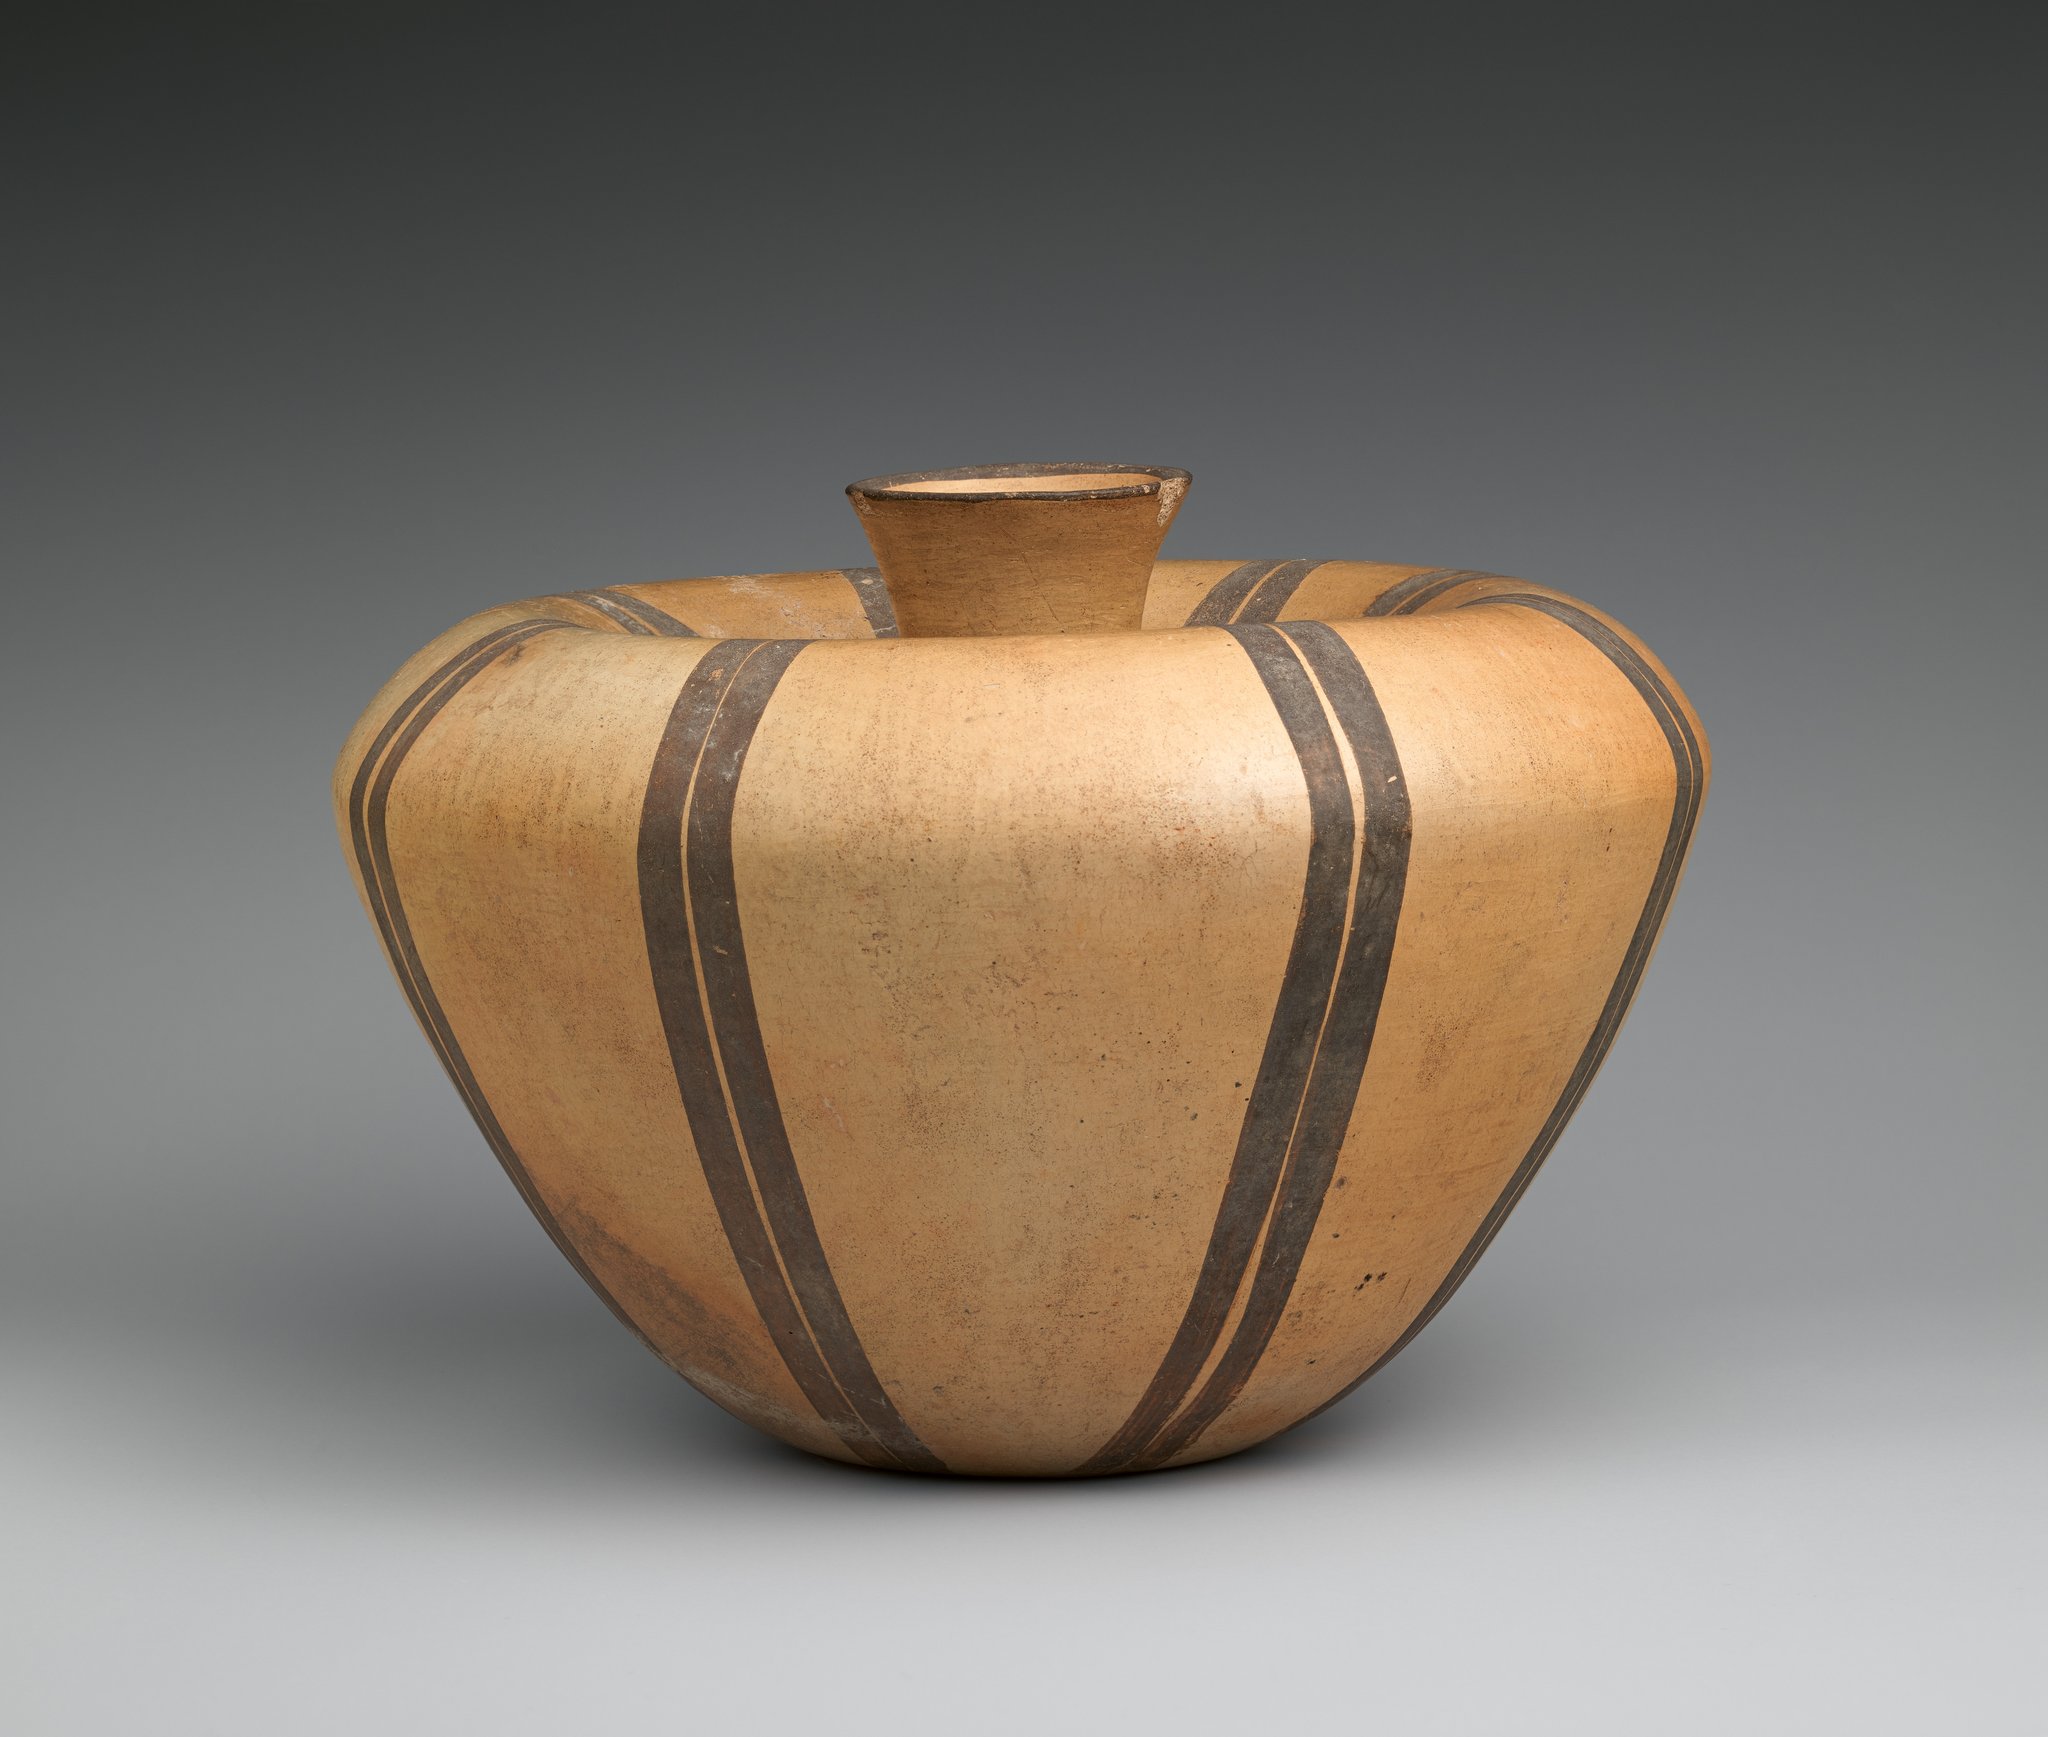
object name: jar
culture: nayarit, chinesco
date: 101-400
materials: ceramic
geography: mexico